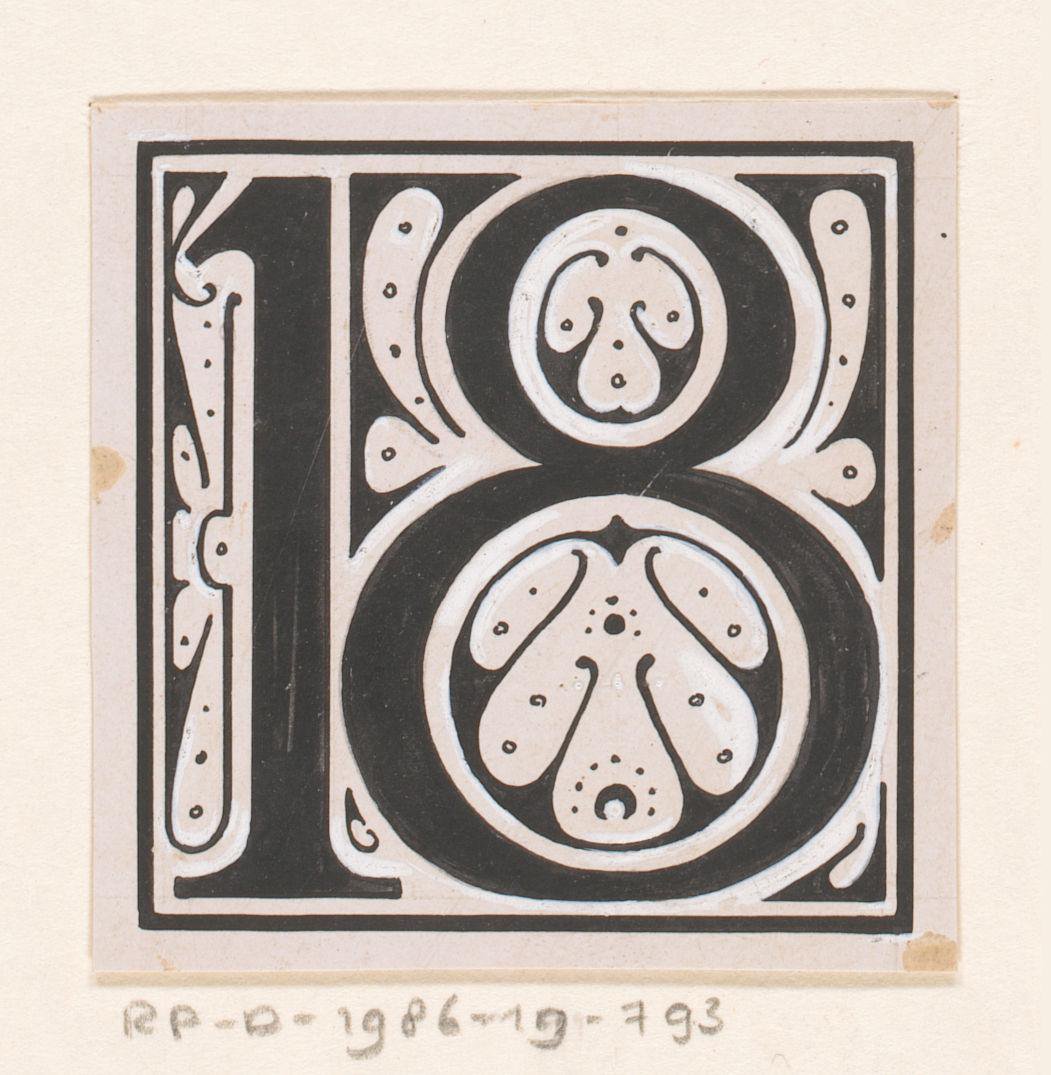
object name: drawing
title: Getal 18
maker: reinier willem petrus de vries (1874-1953)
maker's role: draughtsman, print maker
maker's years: 1874-1953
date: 1904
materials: paint, ink, paper, pencil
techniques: brush, pen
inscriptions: collector's mark: ‘R:MVS.’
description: Het getal is gebruikt voor: Veth, Jan. Jozef Israëls en zijn kunst. Arnhem en Nijmegen: Gebroeders E&M Cohen, 1904.